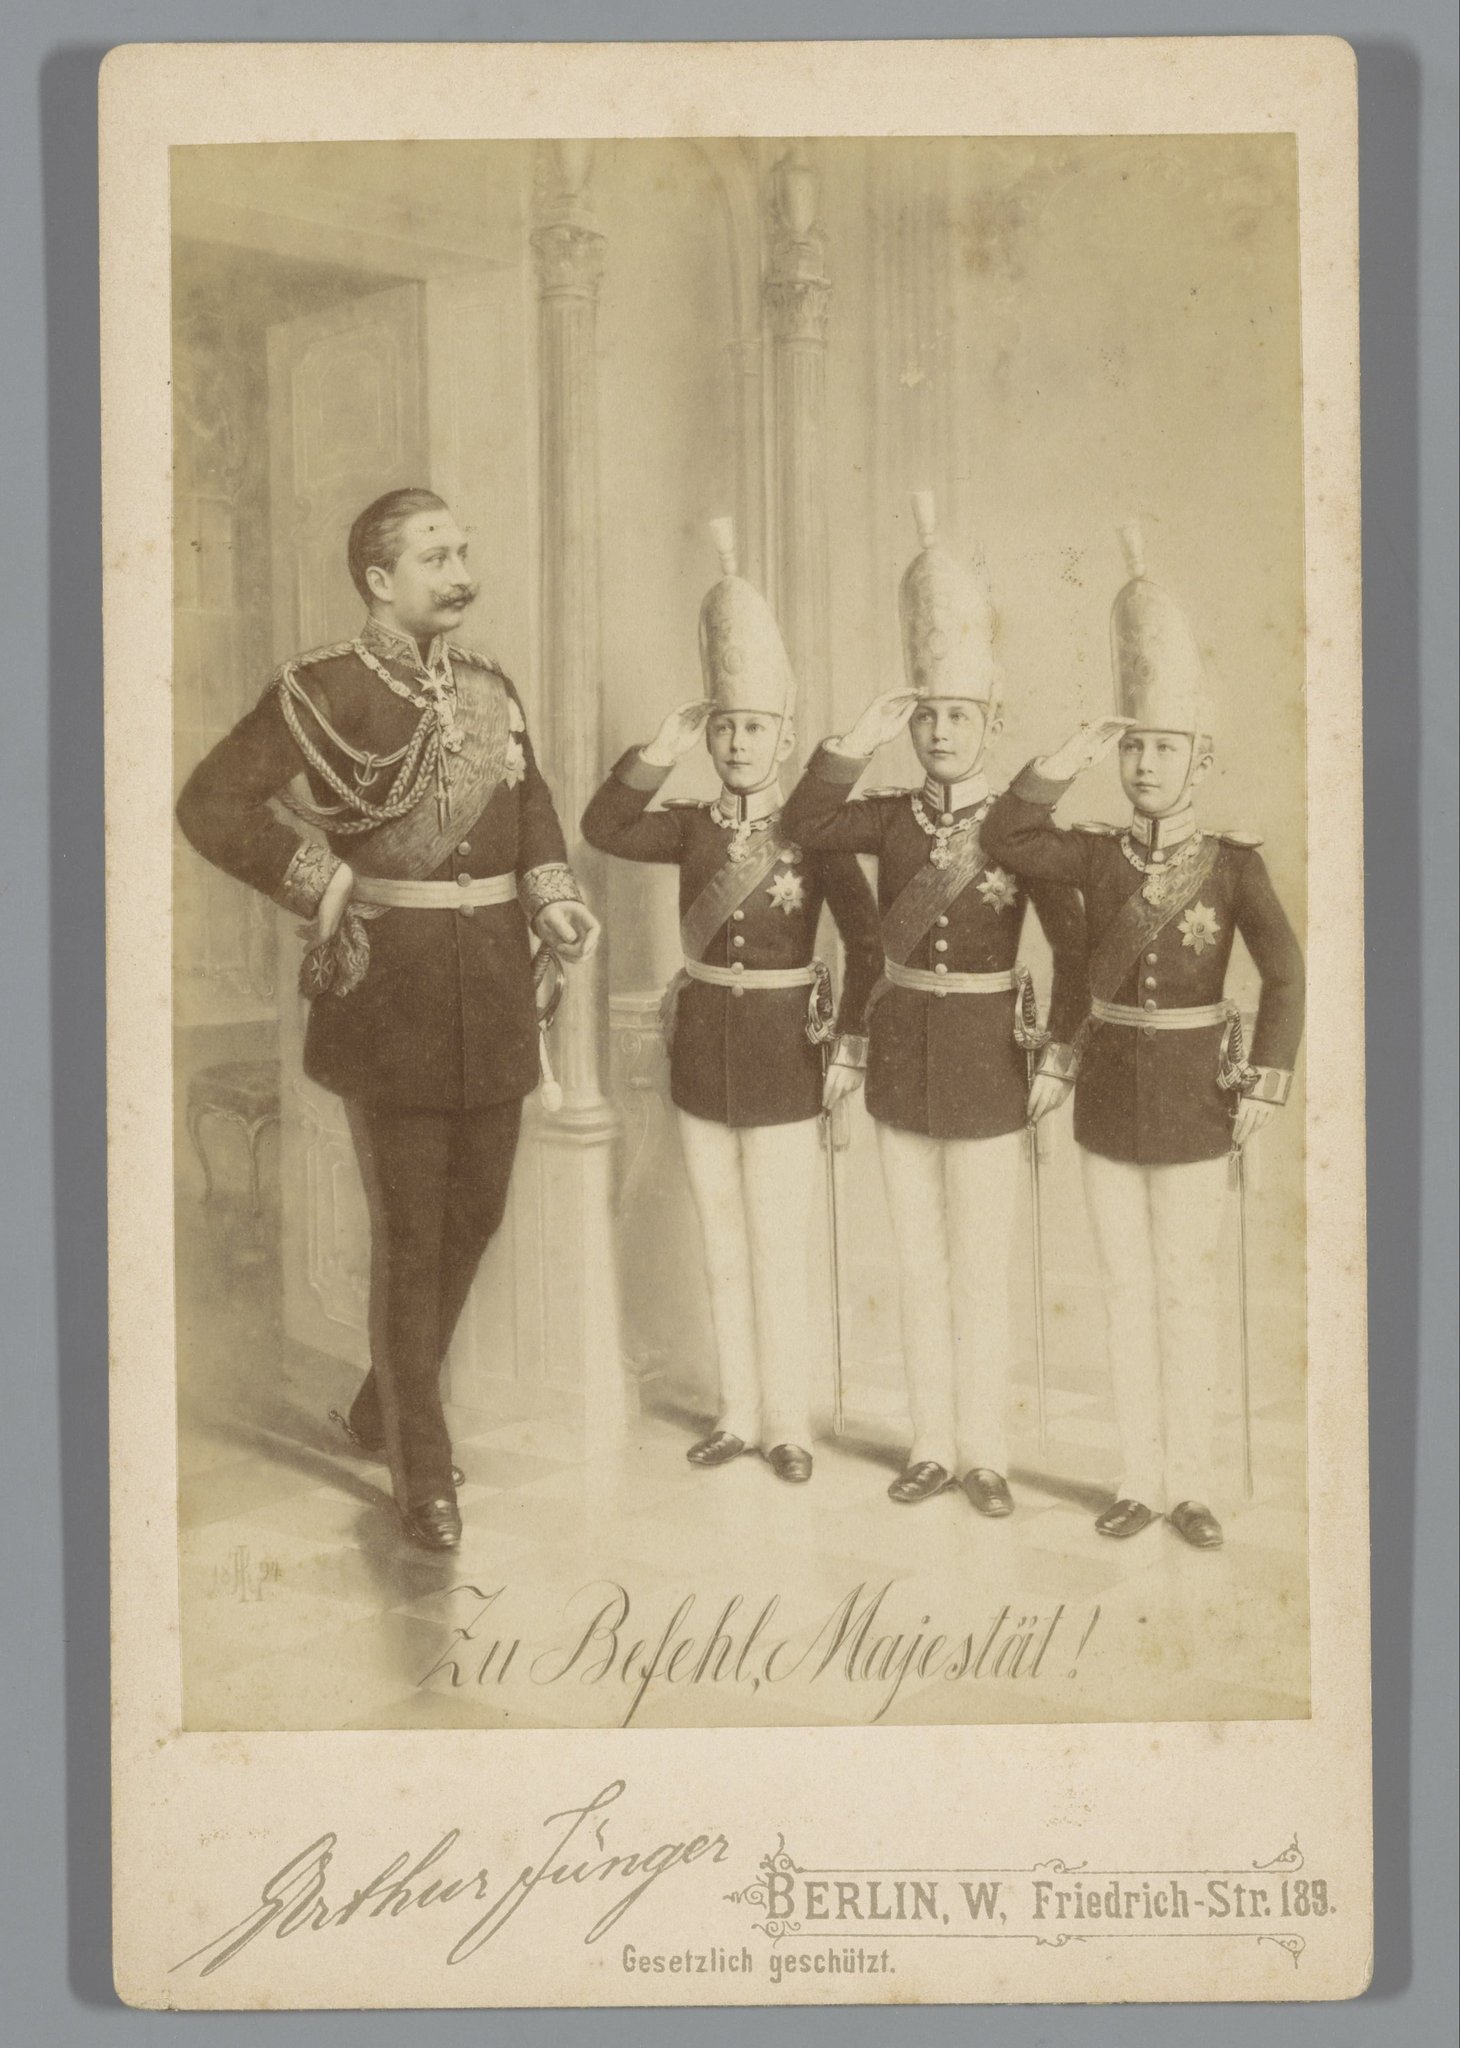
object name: cabinet photograph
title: Fotoreproductie van het schilderij Zu Befehl, Majestät!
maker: arthur jünger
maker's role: fotograaf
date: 1894-1900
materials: cardboard, paper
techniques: albumen print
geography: the hague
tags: wilhelm ii (keizer van duitsland), emperor, military salutes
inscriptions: collector's mark: ‘Vosmaer’, stamp: ‘Librairie artistique/ fondée 1813/ A. van Hoogstraten et Fils/ Fournisseurs de la Cour/ Plaats 11 - La Haye.’